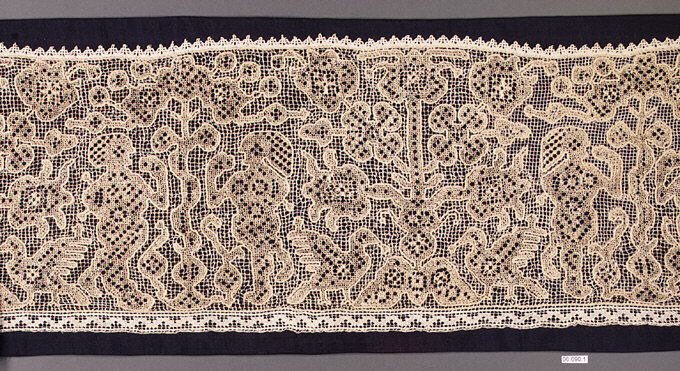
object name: strip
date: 1567-1600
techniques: embroidery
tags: human figures,birds,flowers